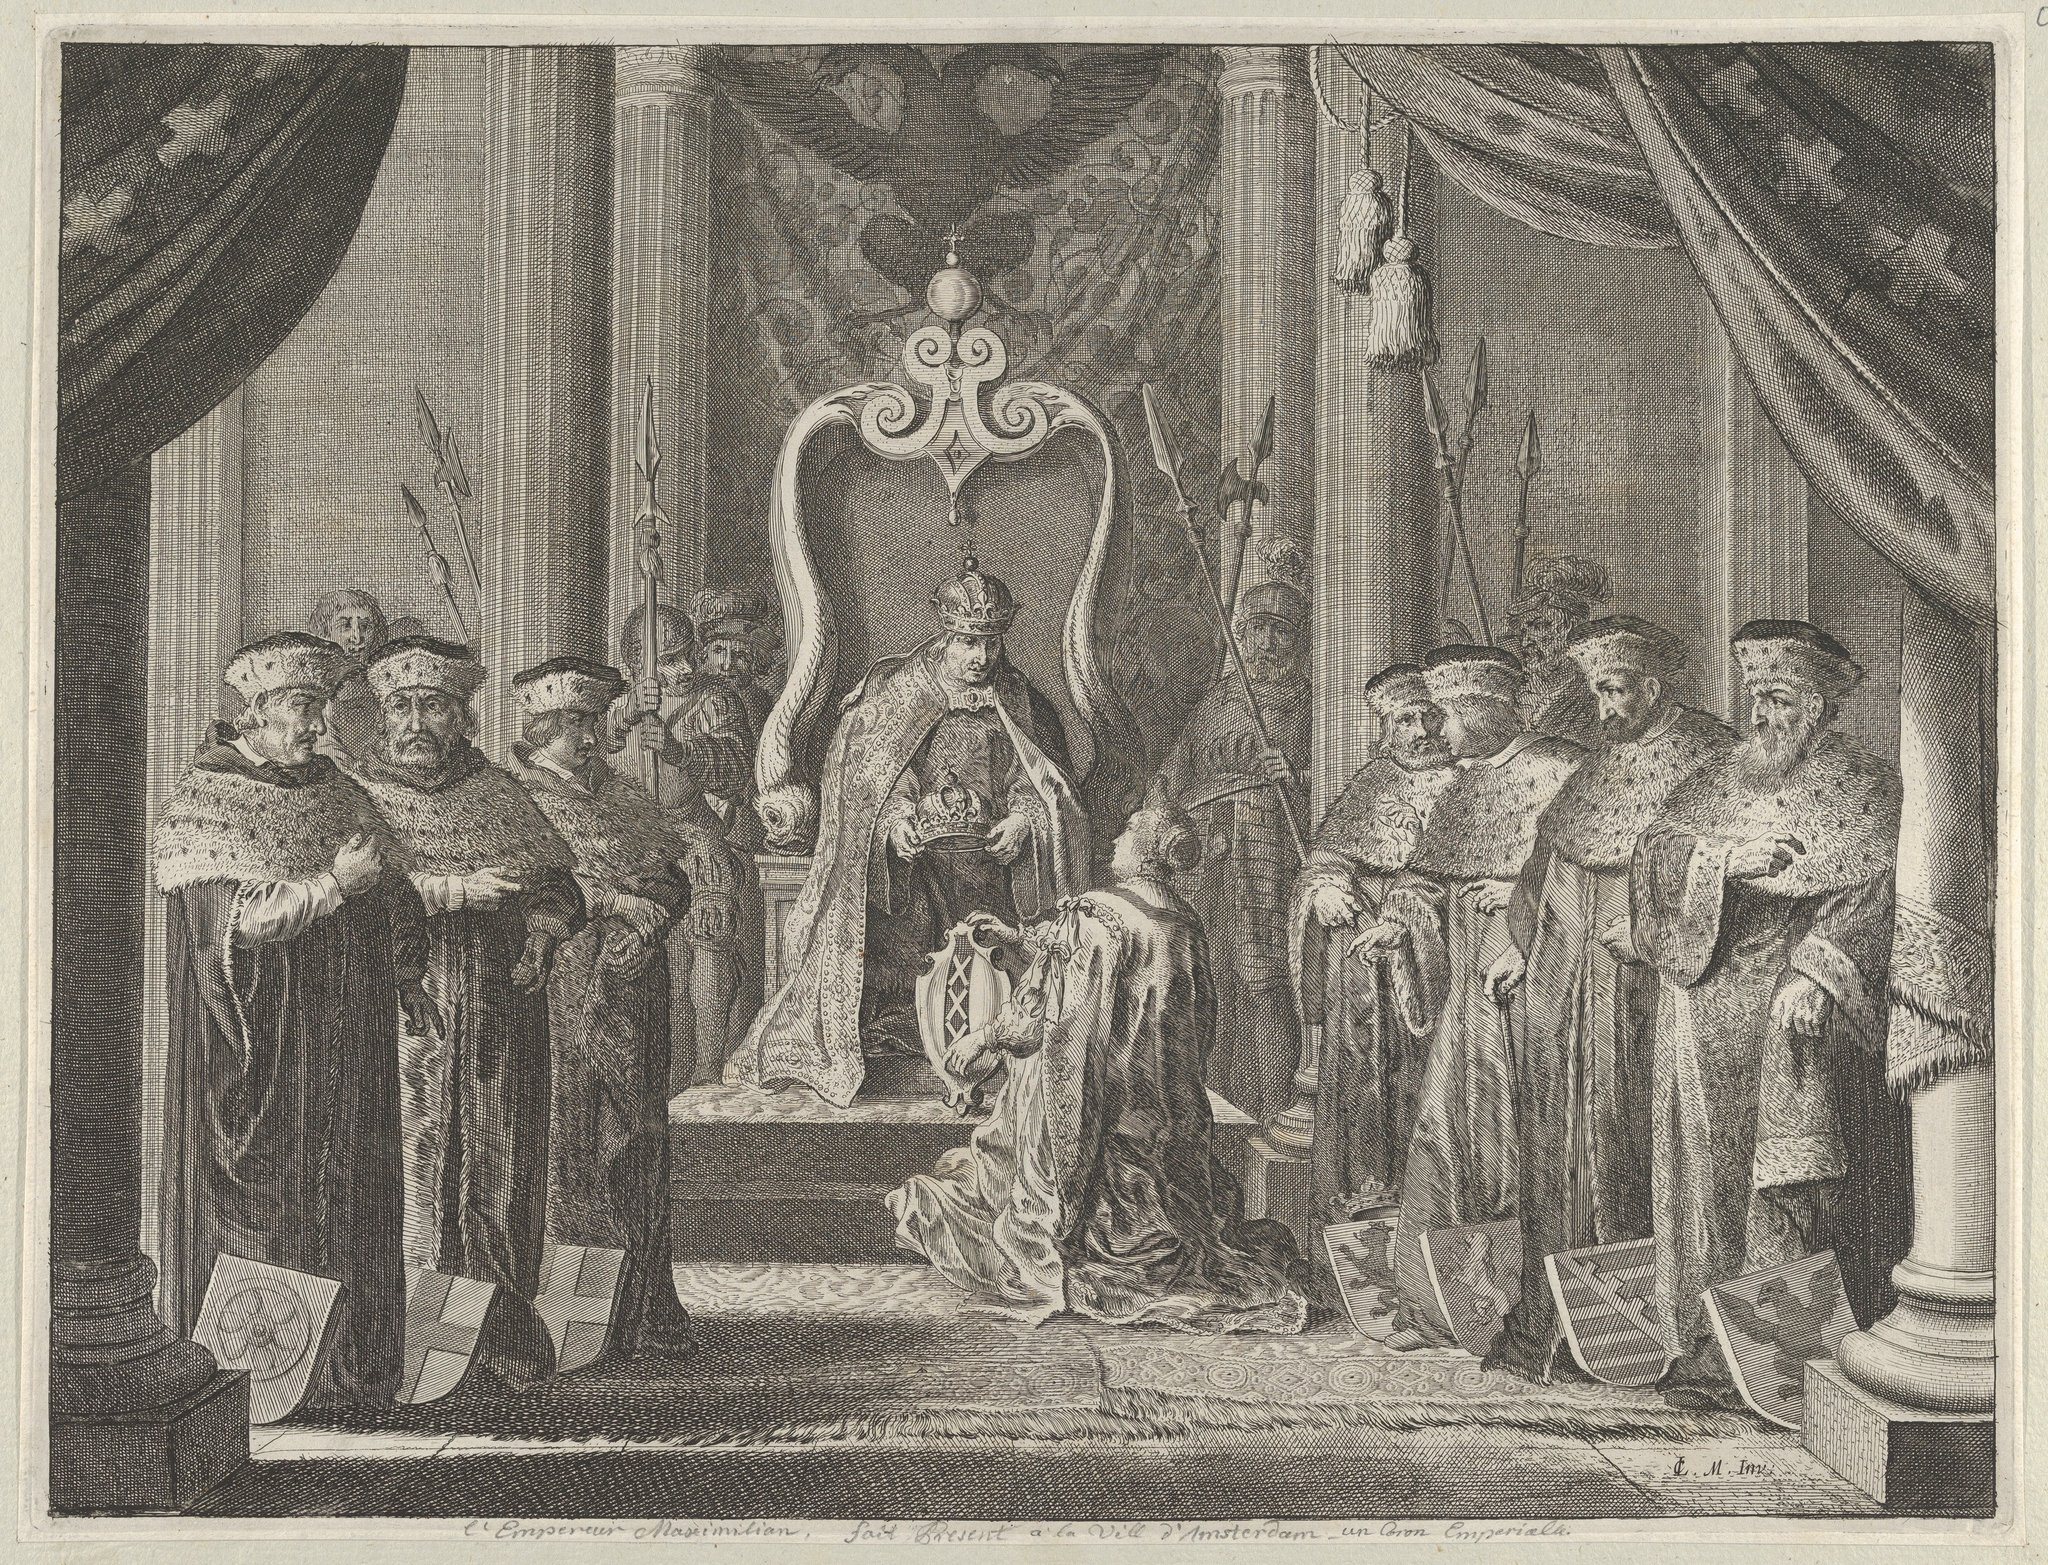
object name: print, fete, ornament architecture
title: Plate 8: Emperor Maximilian II granting a crown to the coat of arms of Amsterdam, from Caspar Barlaeus, "Medicea Hospes"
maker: pieter nolpe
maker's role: artist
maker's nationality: dutch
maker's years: 1613-1614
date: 1638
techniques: etching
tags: soldiers,spears,kings,men,coat of arms